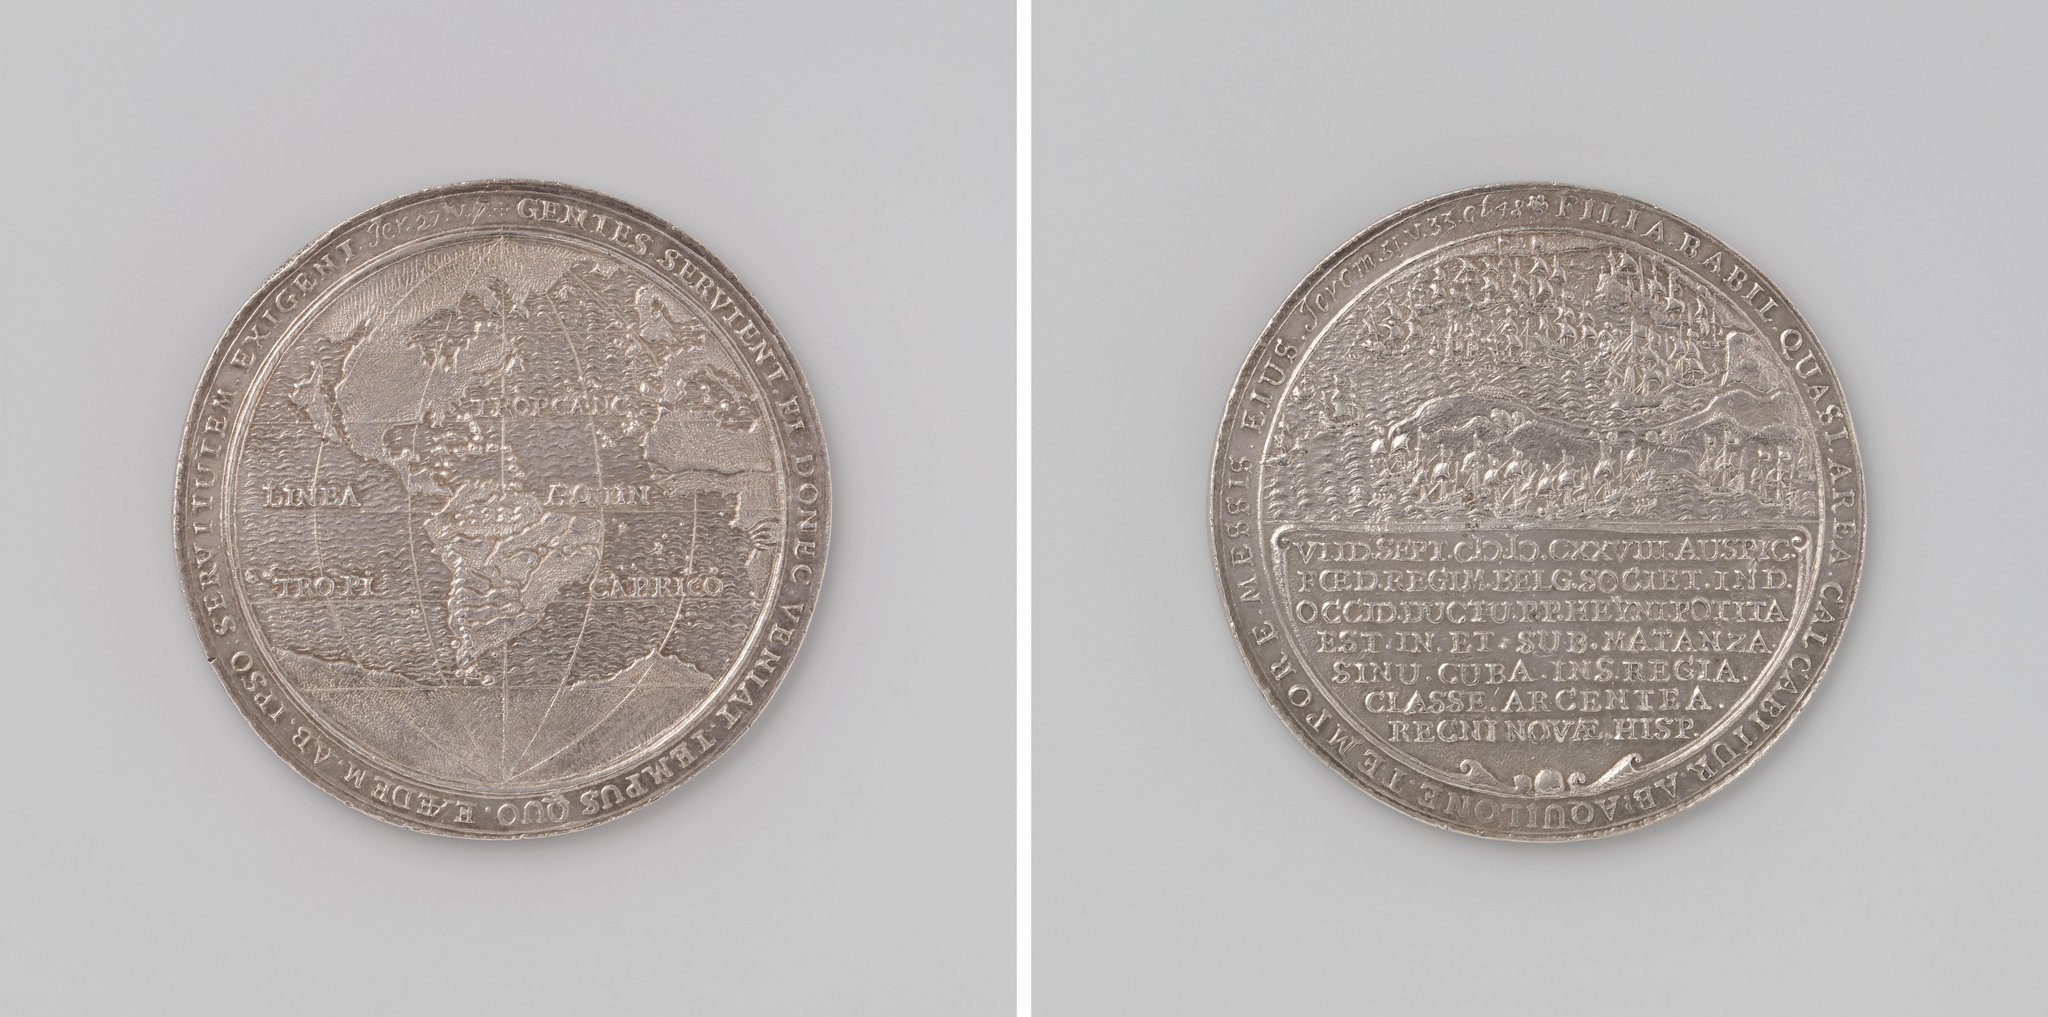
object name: history medal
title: Verovering van de zilvervloot door Piet Hein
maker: laurens van teylingen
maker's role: mintmaster, print maker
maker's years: -1637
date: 1629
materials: silver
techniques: striking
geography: netherlands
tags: capture of the spanish treasure fleet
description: Triomfpenning van de verovering van de zilvervloot door Piet Hein. Voorzijde: landkaart van Noord- en Zuid-Amerika binnen omschrift. Keerzijde: schepen in en rond baai boven cartouche met opschrift binnen omschrift.